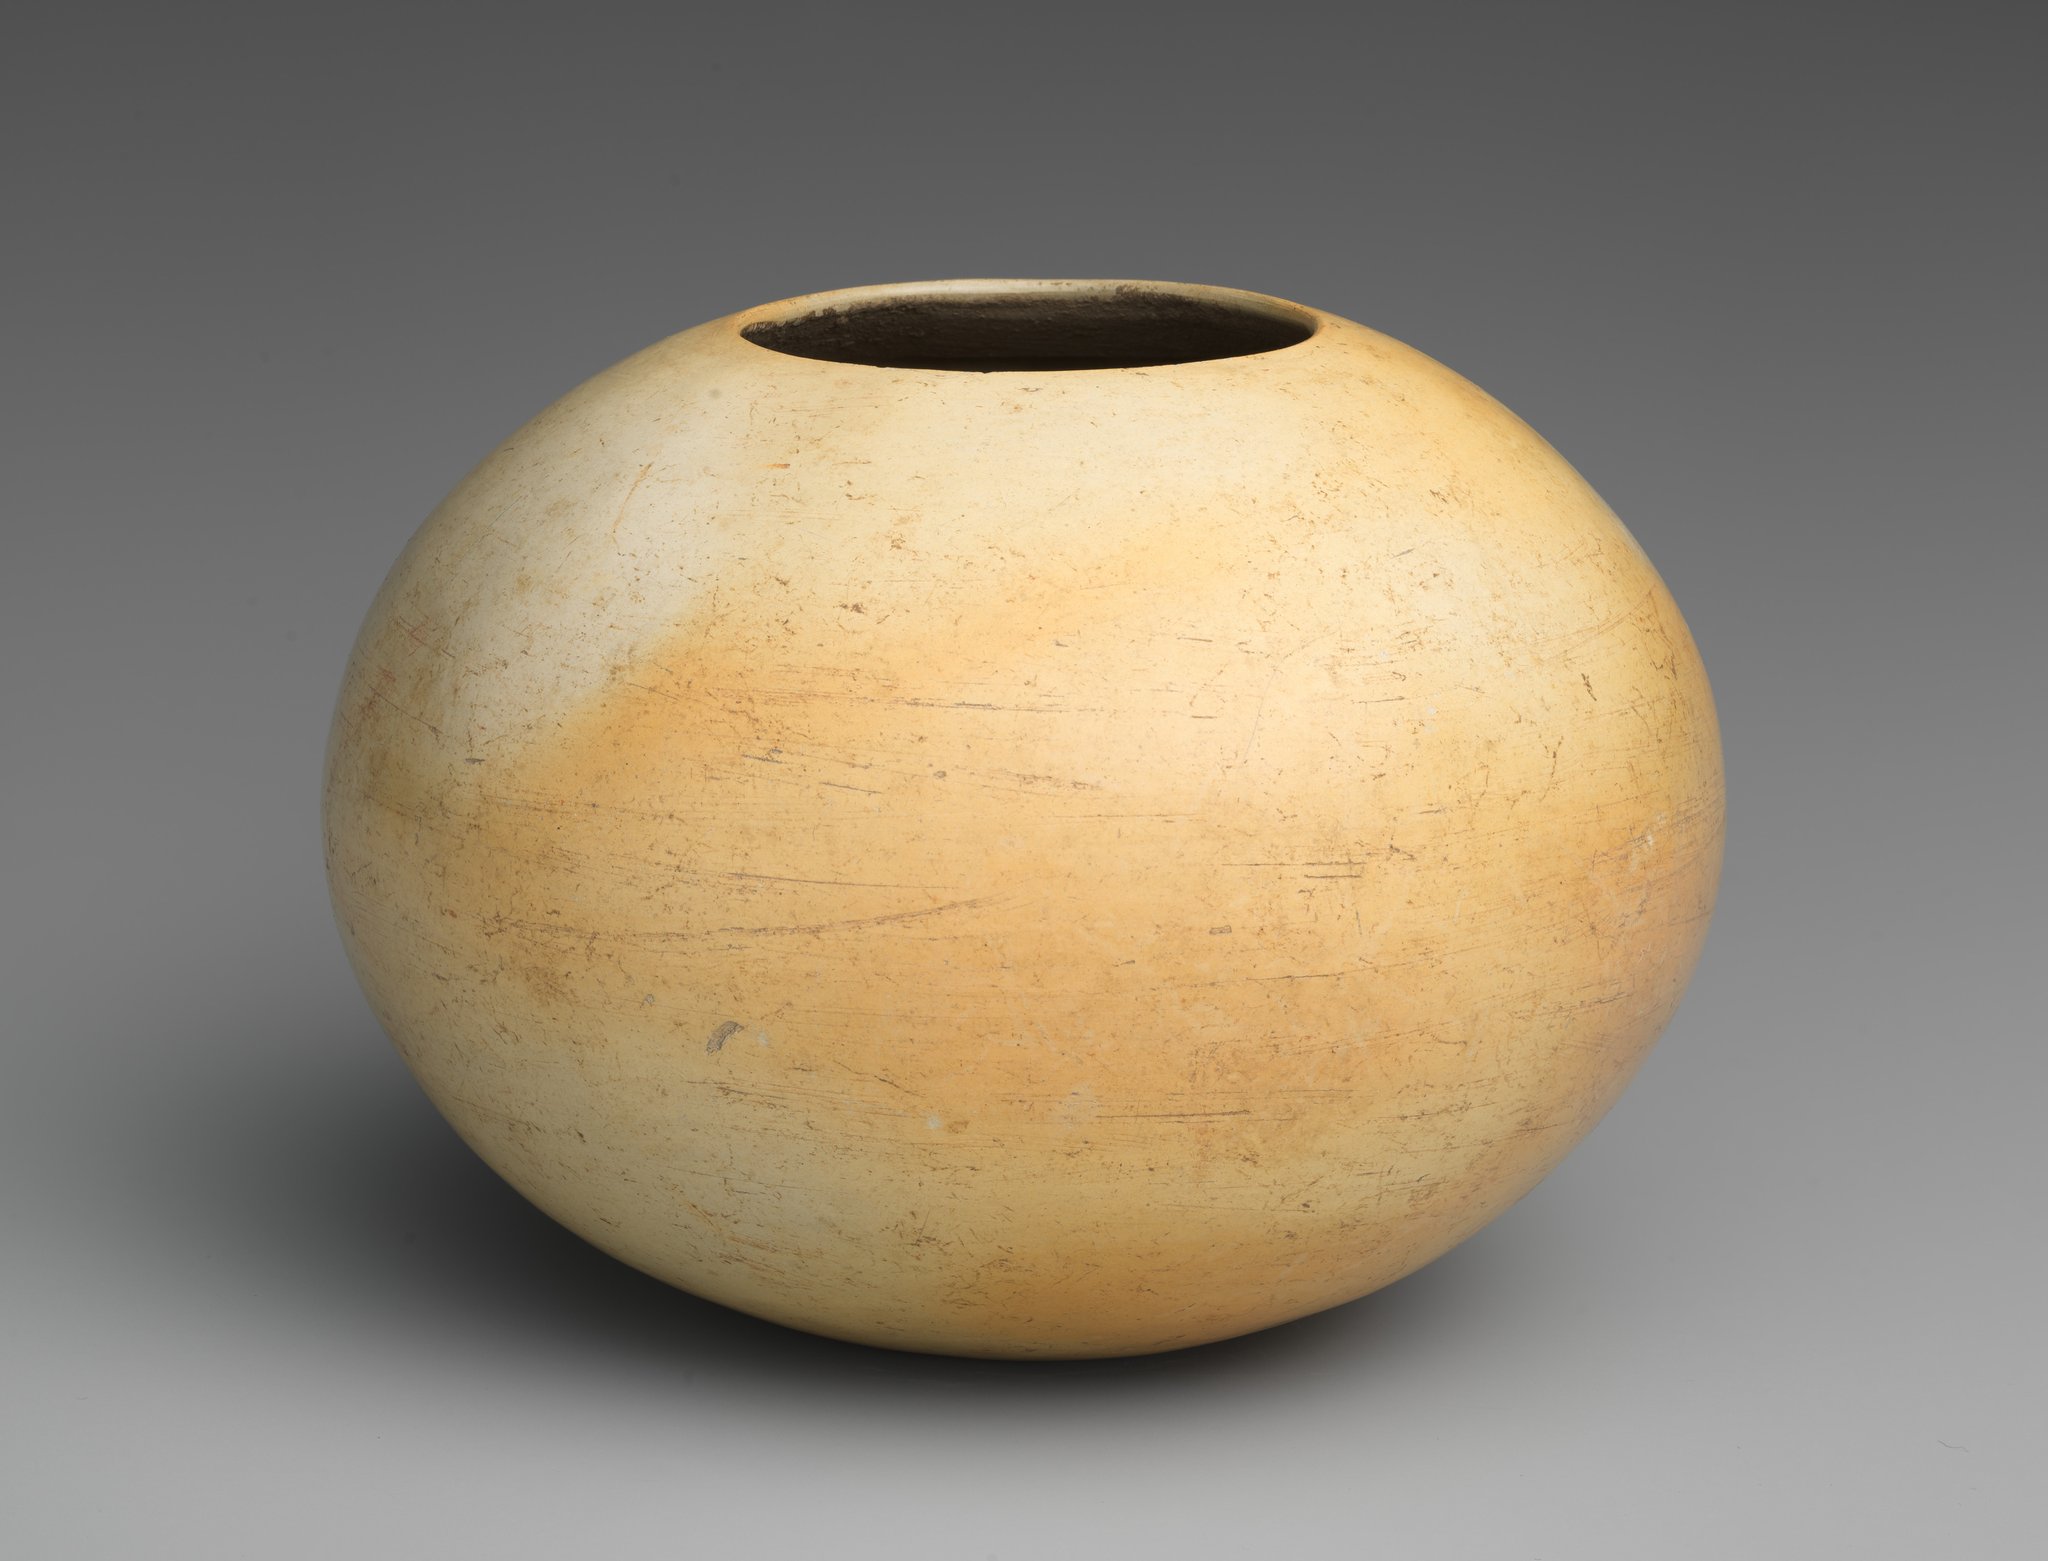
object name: bowl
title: Bowl (Tecomate)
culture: olmec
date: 1200-801 BCE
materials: ceramic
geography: mexico